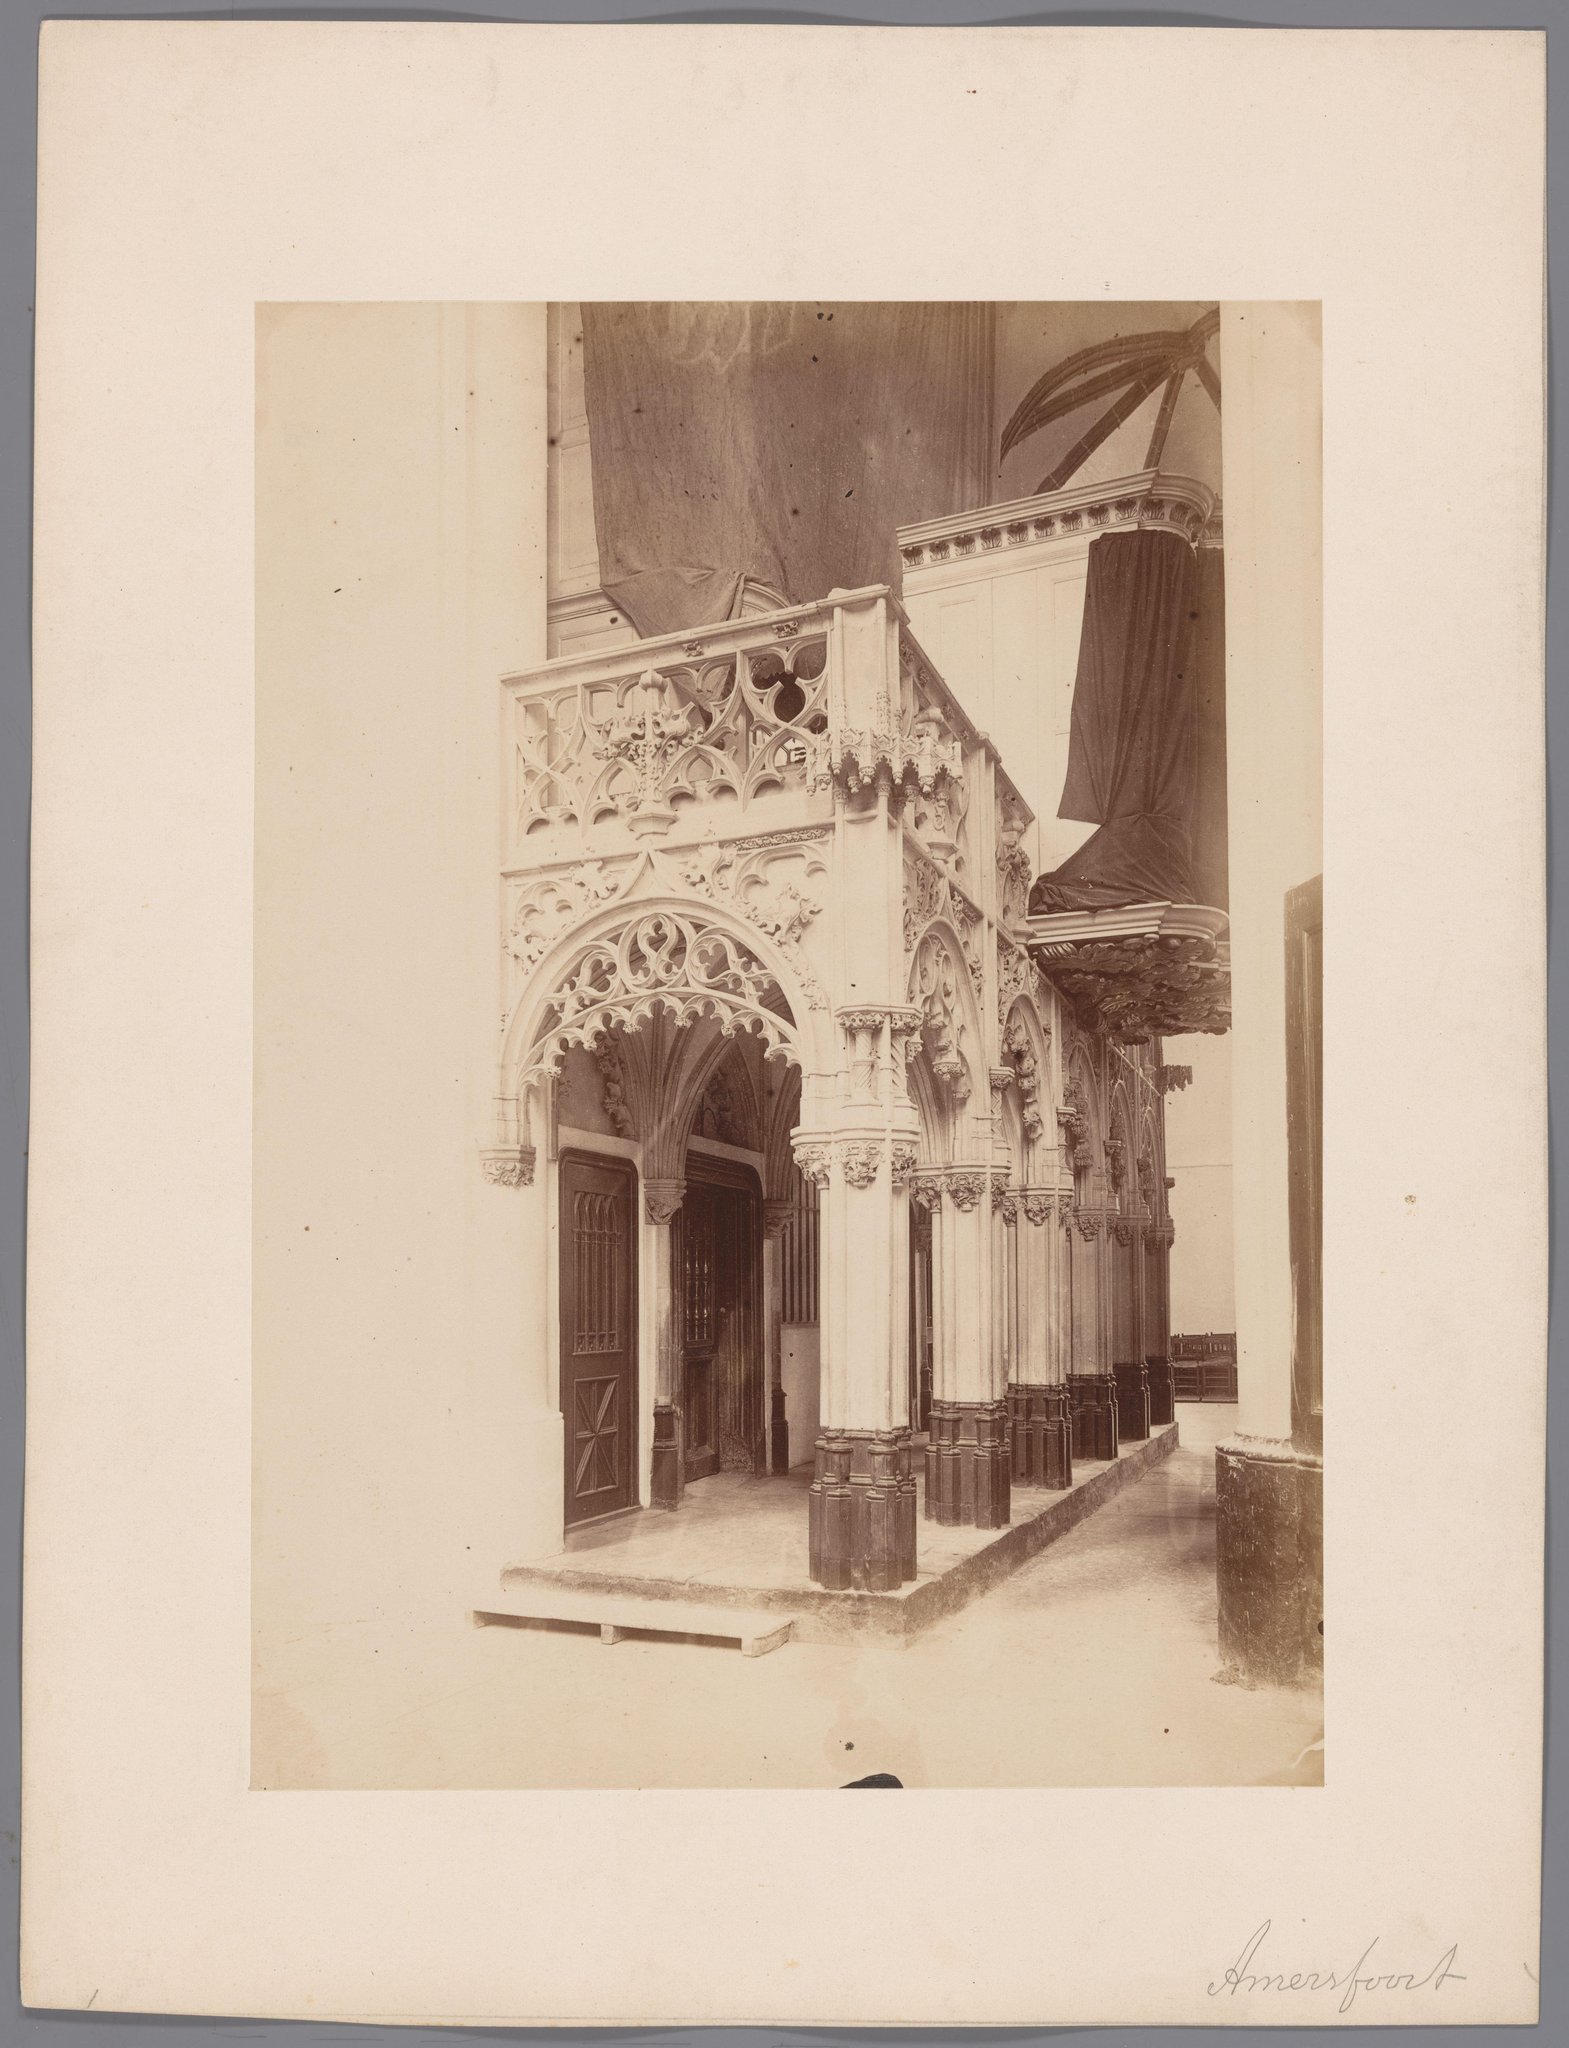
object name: photograph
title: Interieur van de Sint-Joriskerk te Amersfoort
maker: anoniem (monumentenzorg)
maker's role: fotograaf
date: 1891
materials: cardboard, photographic support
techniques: albumen print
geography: amersfoort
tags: interior of church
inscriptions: annotation: ‘Amersfoort’, annotation: ‘Amersfoort S. Joriskerk Juli/ sept 1891’